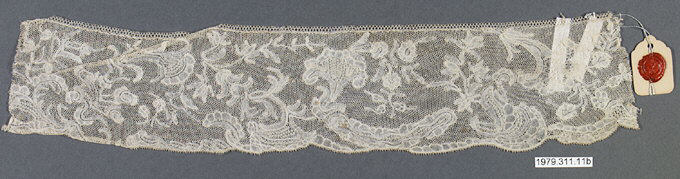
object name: edging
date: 1734-1766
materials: lace, linen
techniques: lace